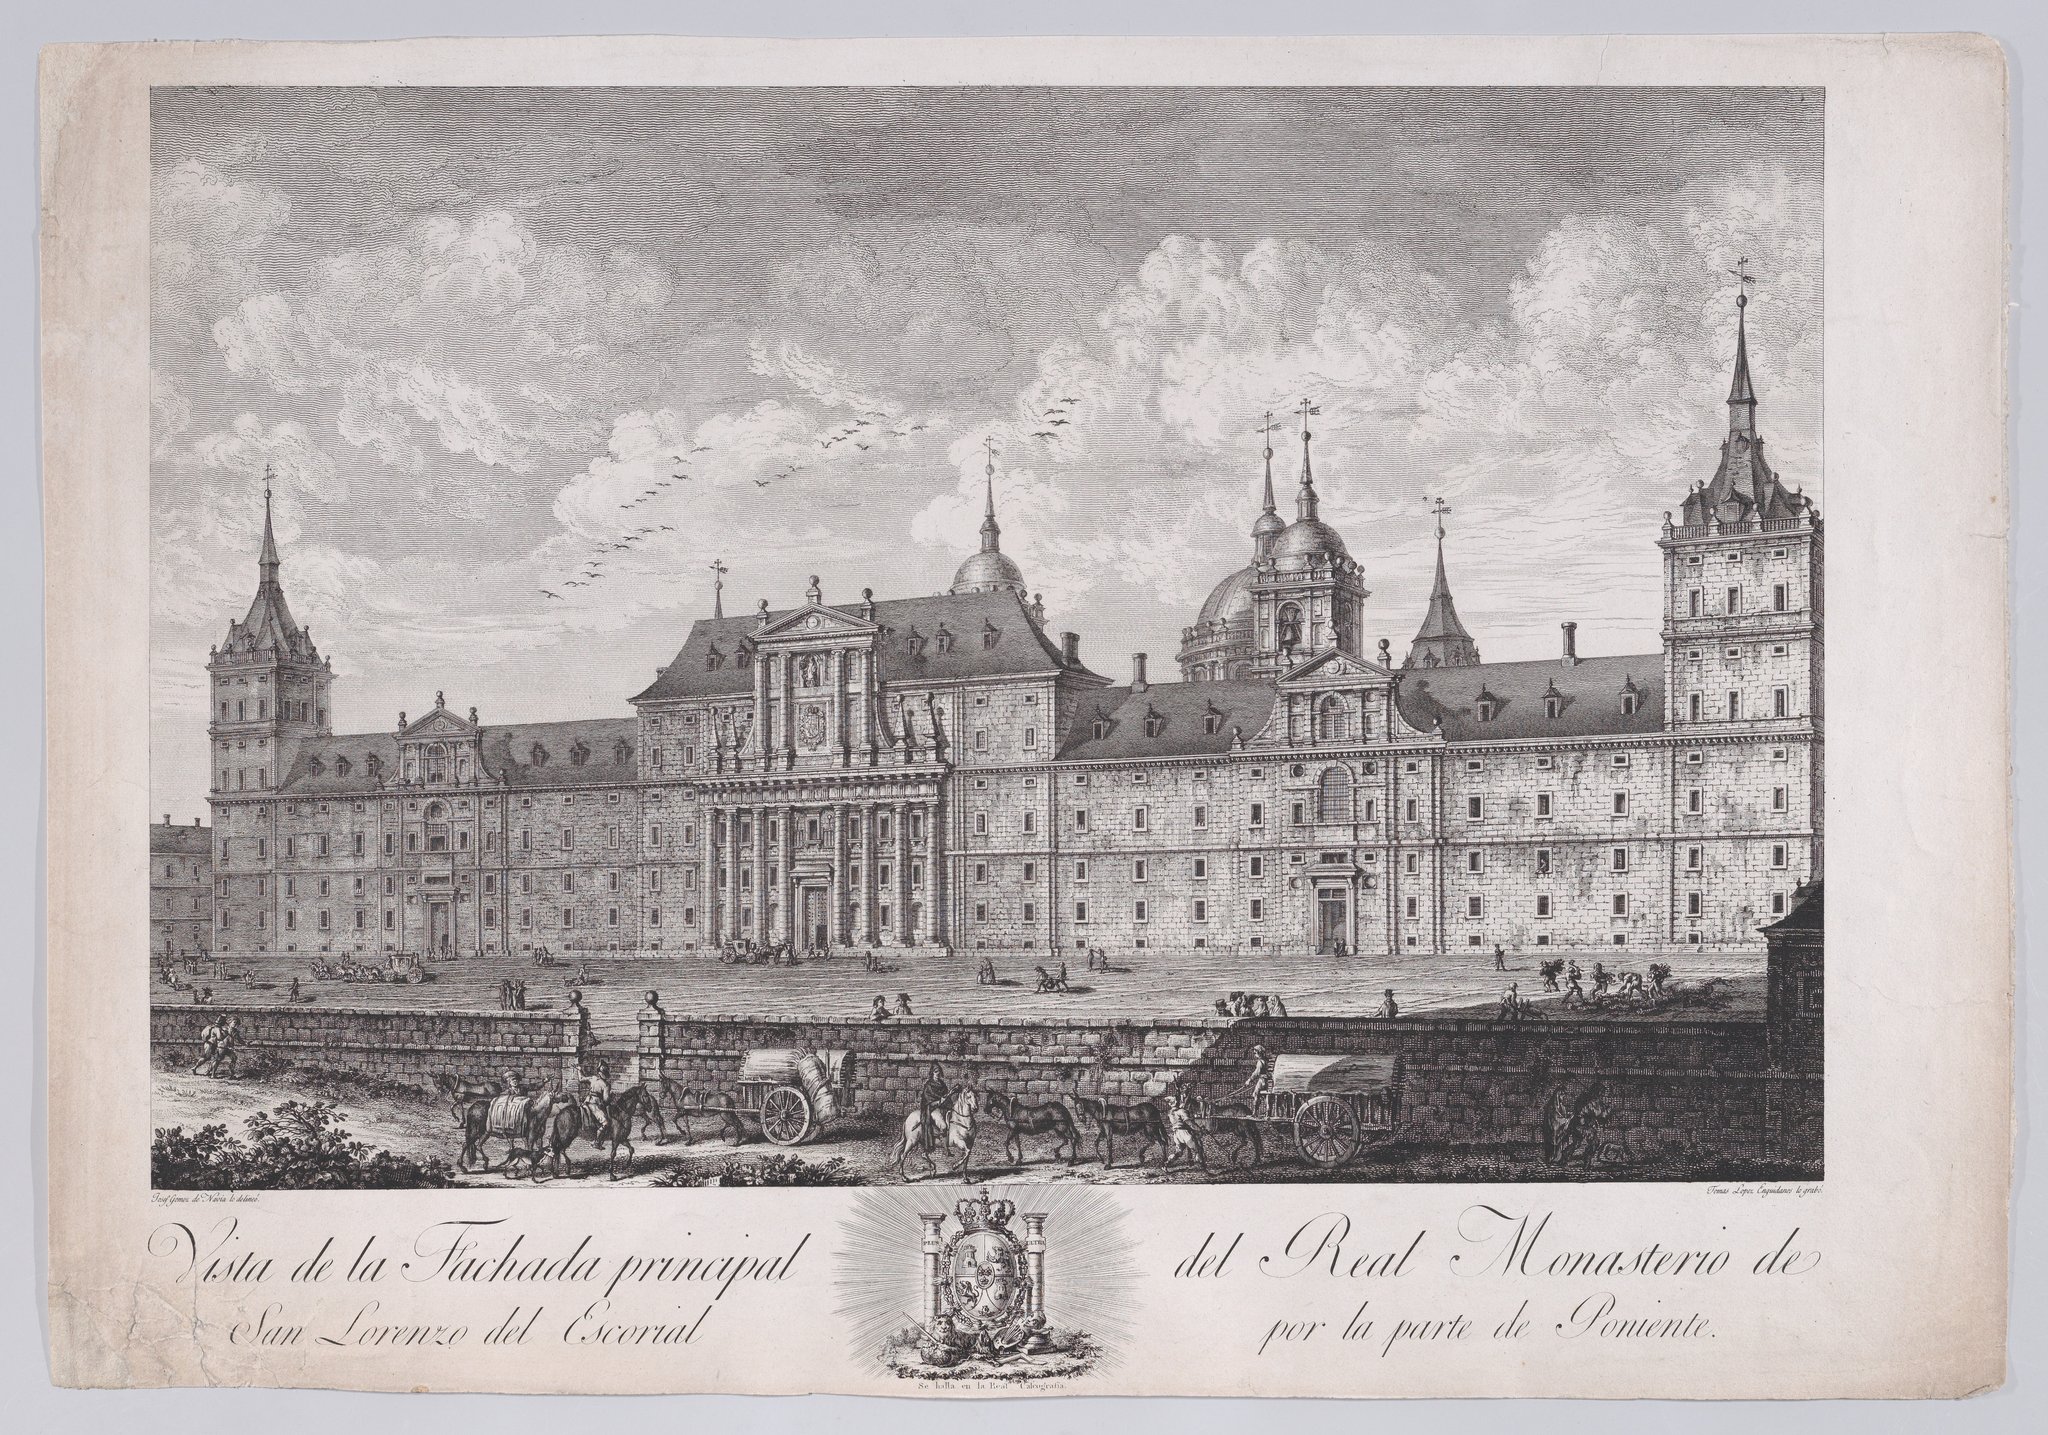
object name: print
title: The main façade of the monastery of El Escorial, from "Views of El Escorial"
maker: tomás lópez enguidanos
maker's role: artist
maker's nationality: spanish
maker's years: 1760-1814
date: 1790-1800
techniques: engraving, etching